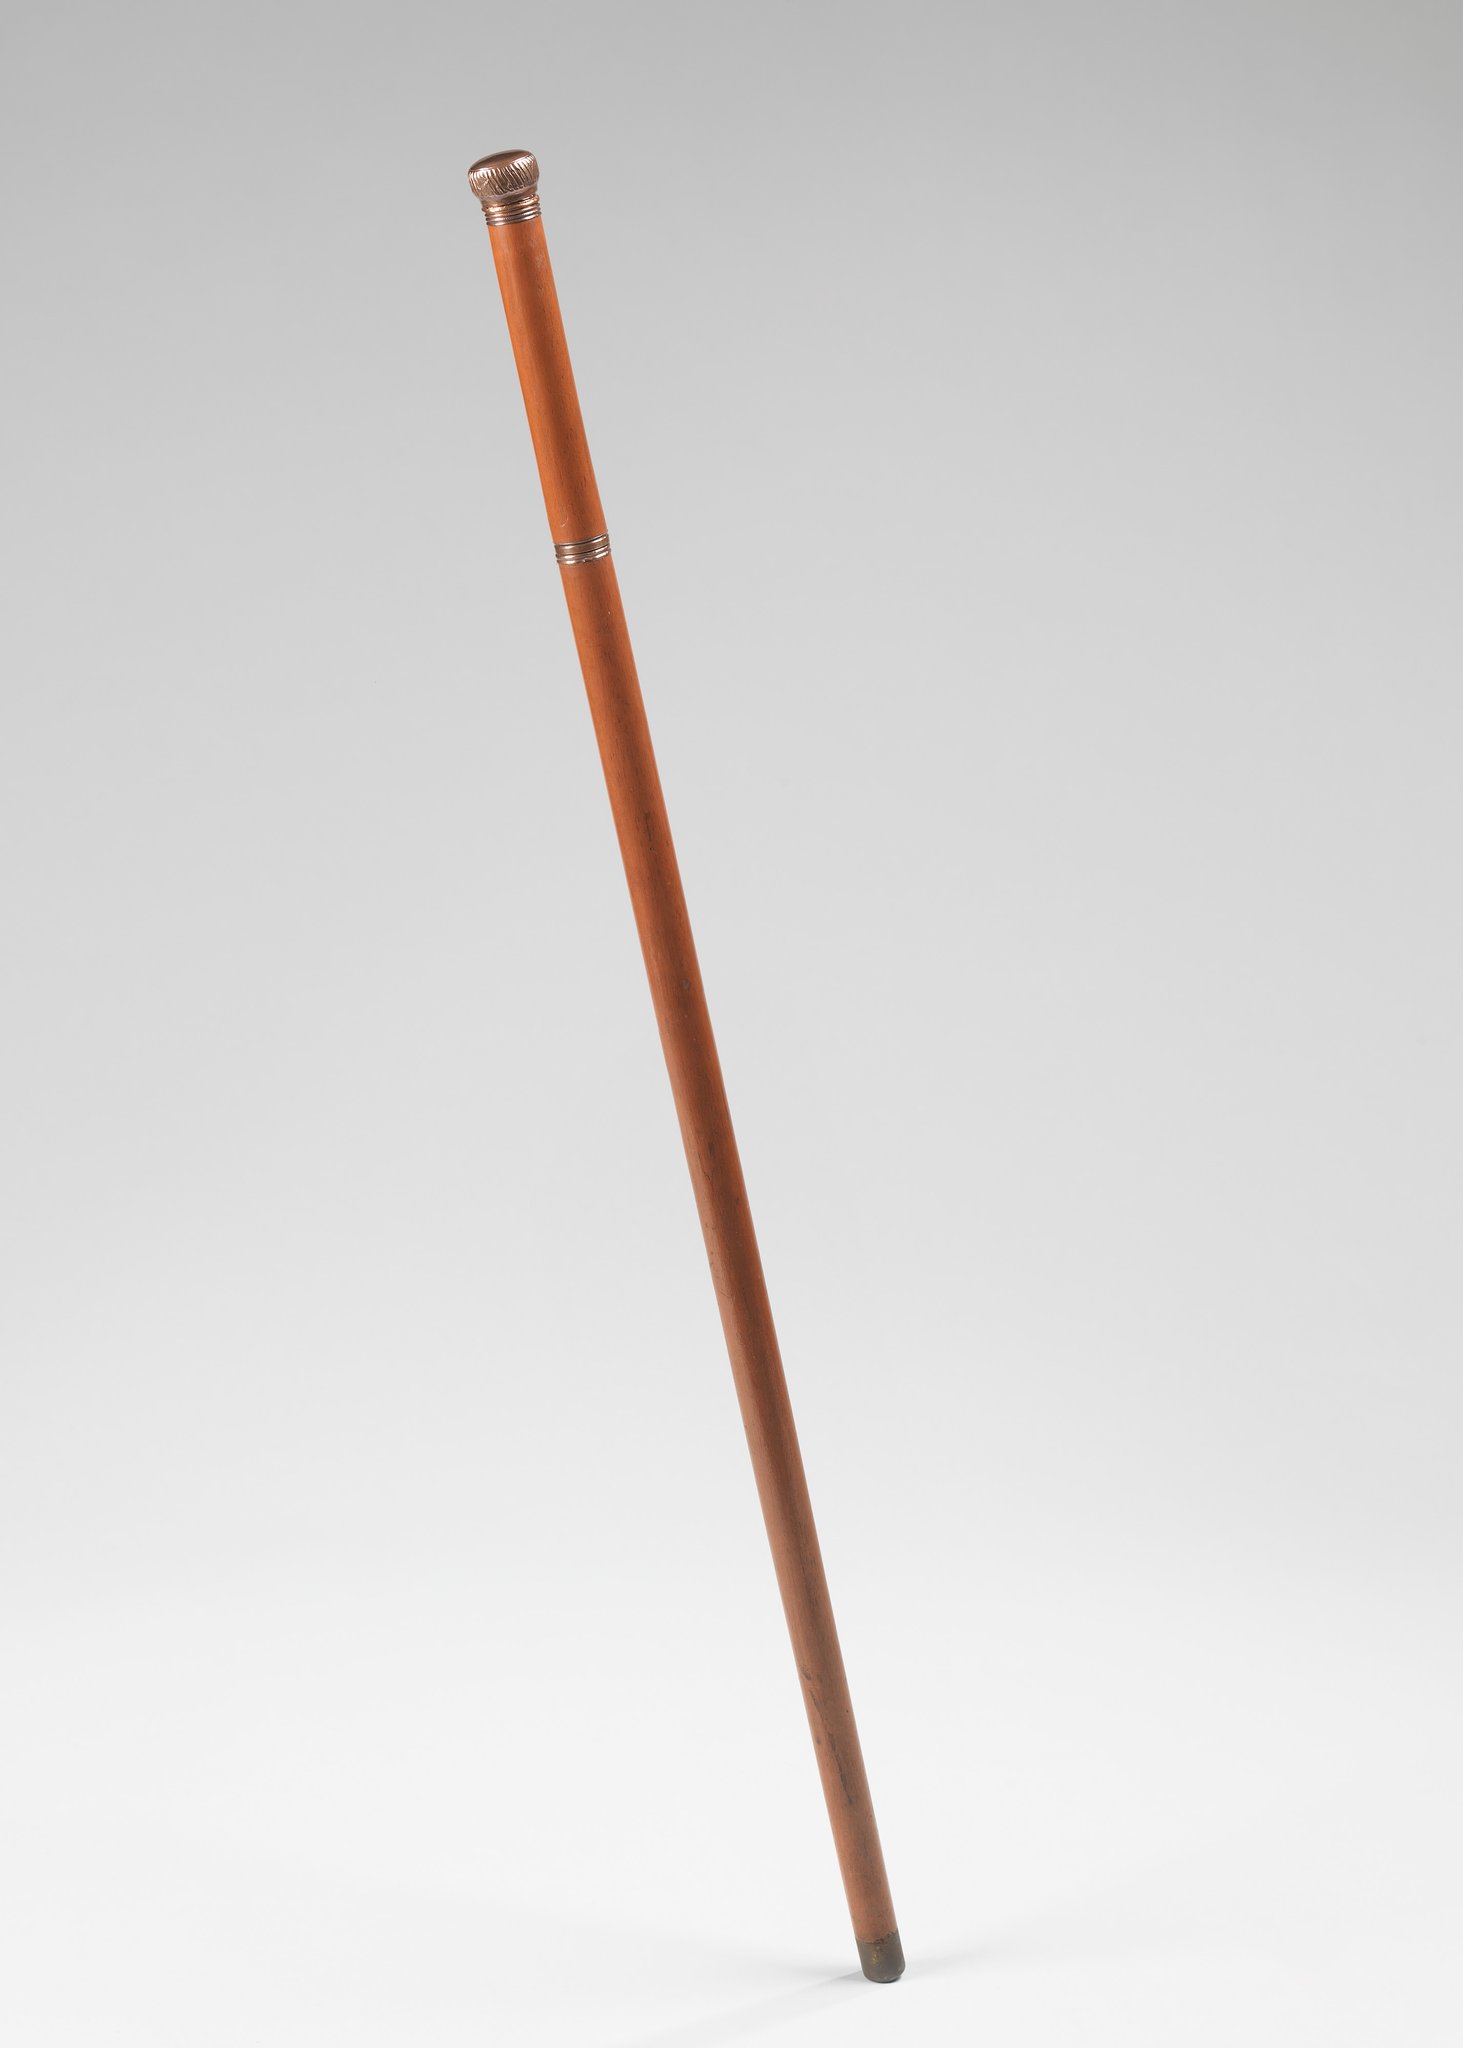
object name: cane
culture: american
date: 1885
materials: glass, metal, wood